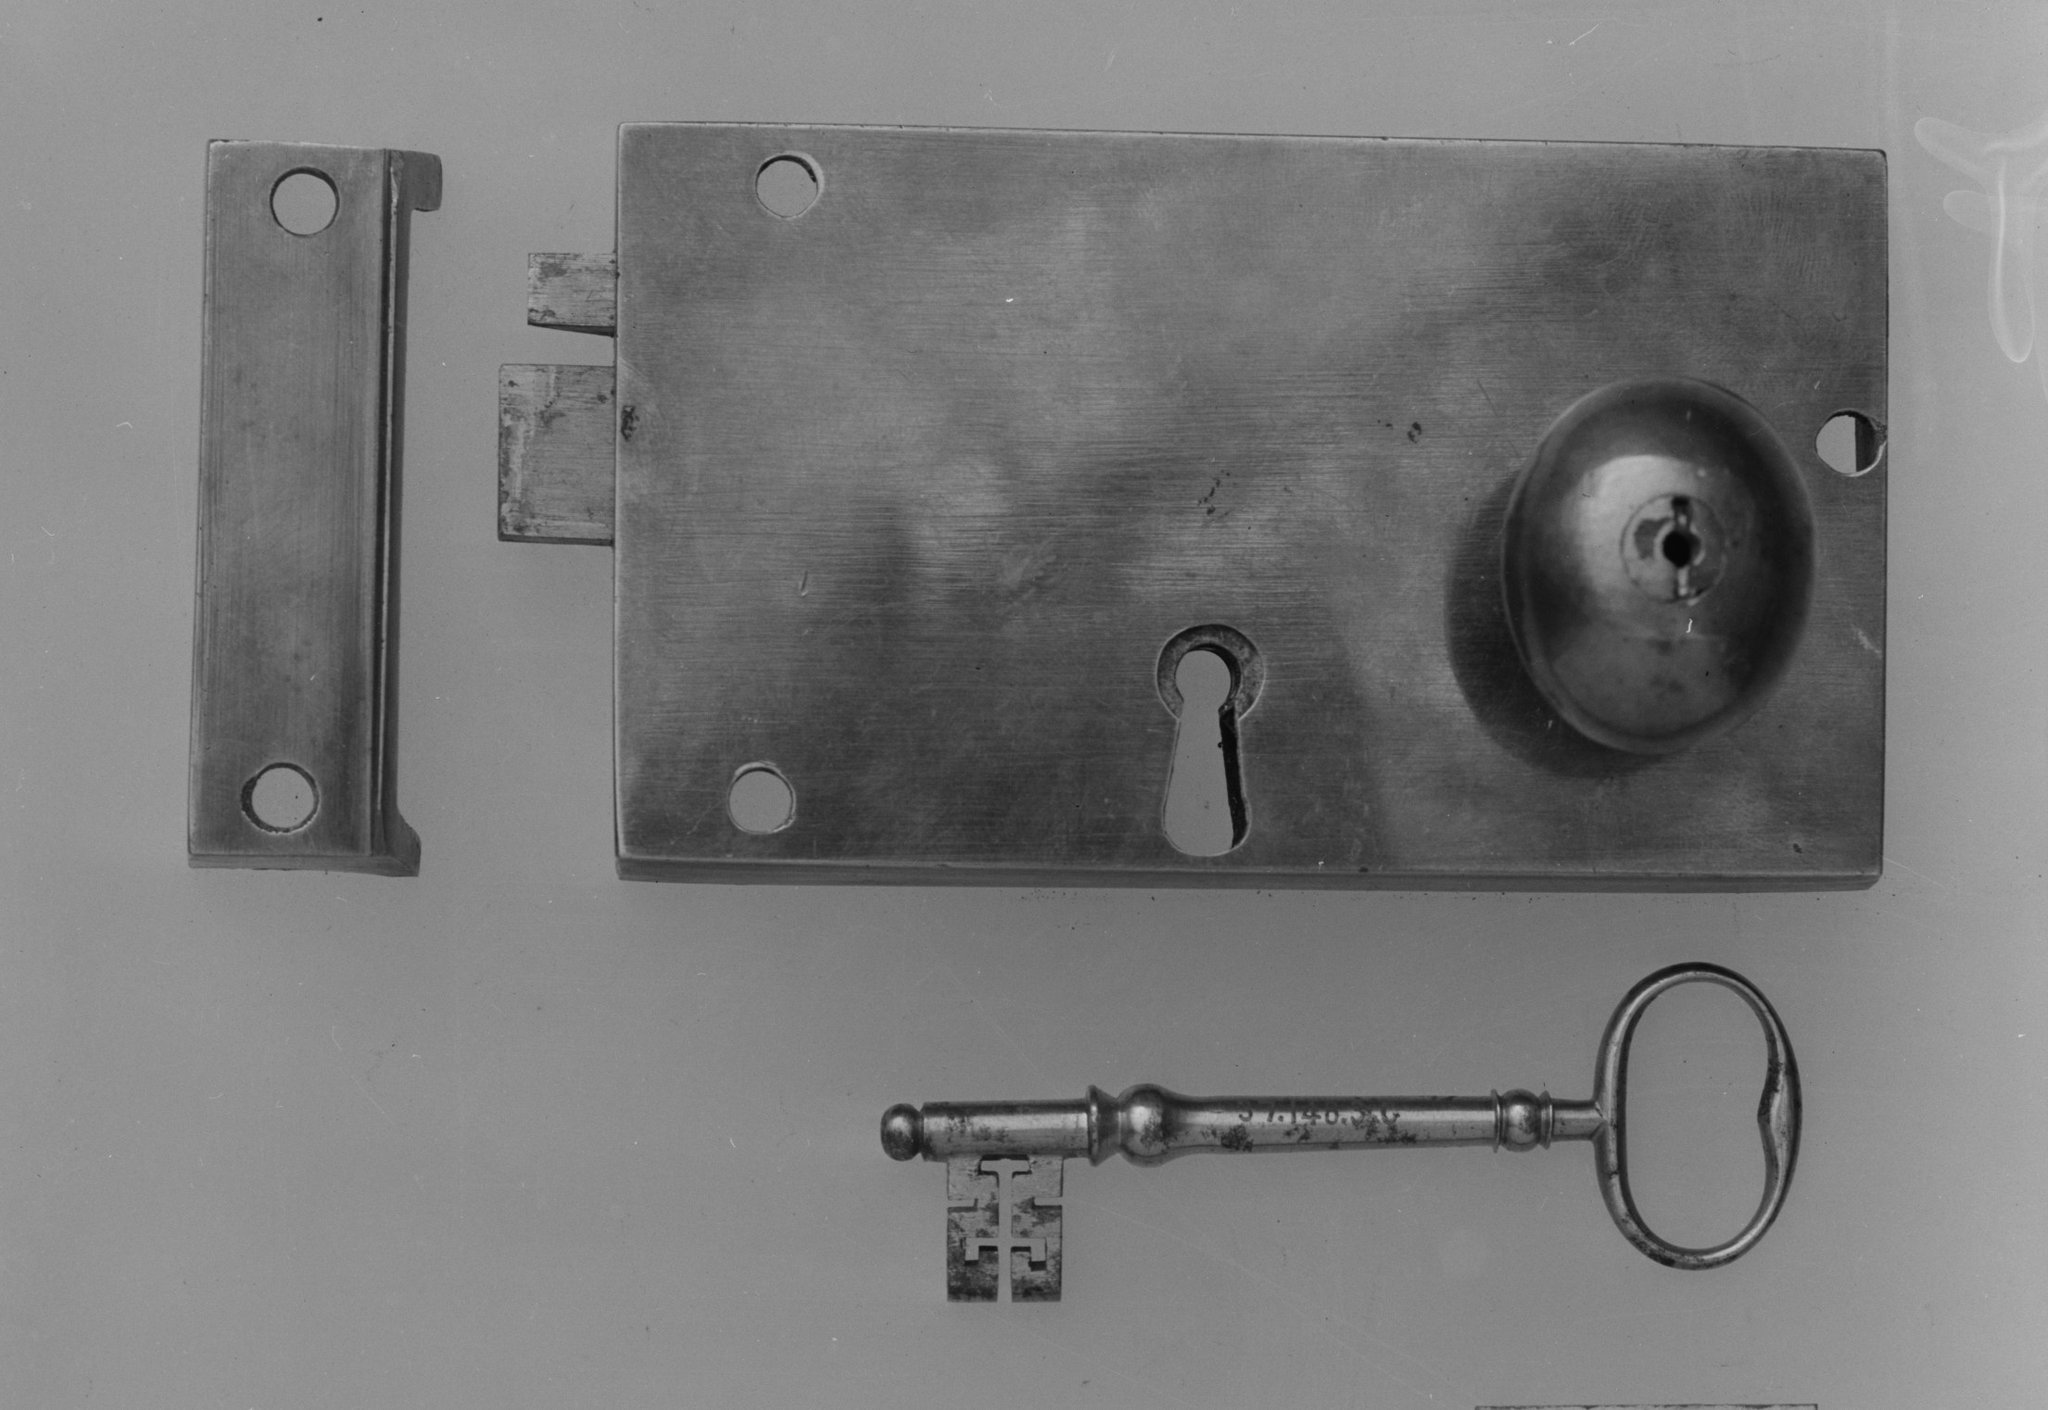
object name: lock and key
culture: american or british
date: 1700-1800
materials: brass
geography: england